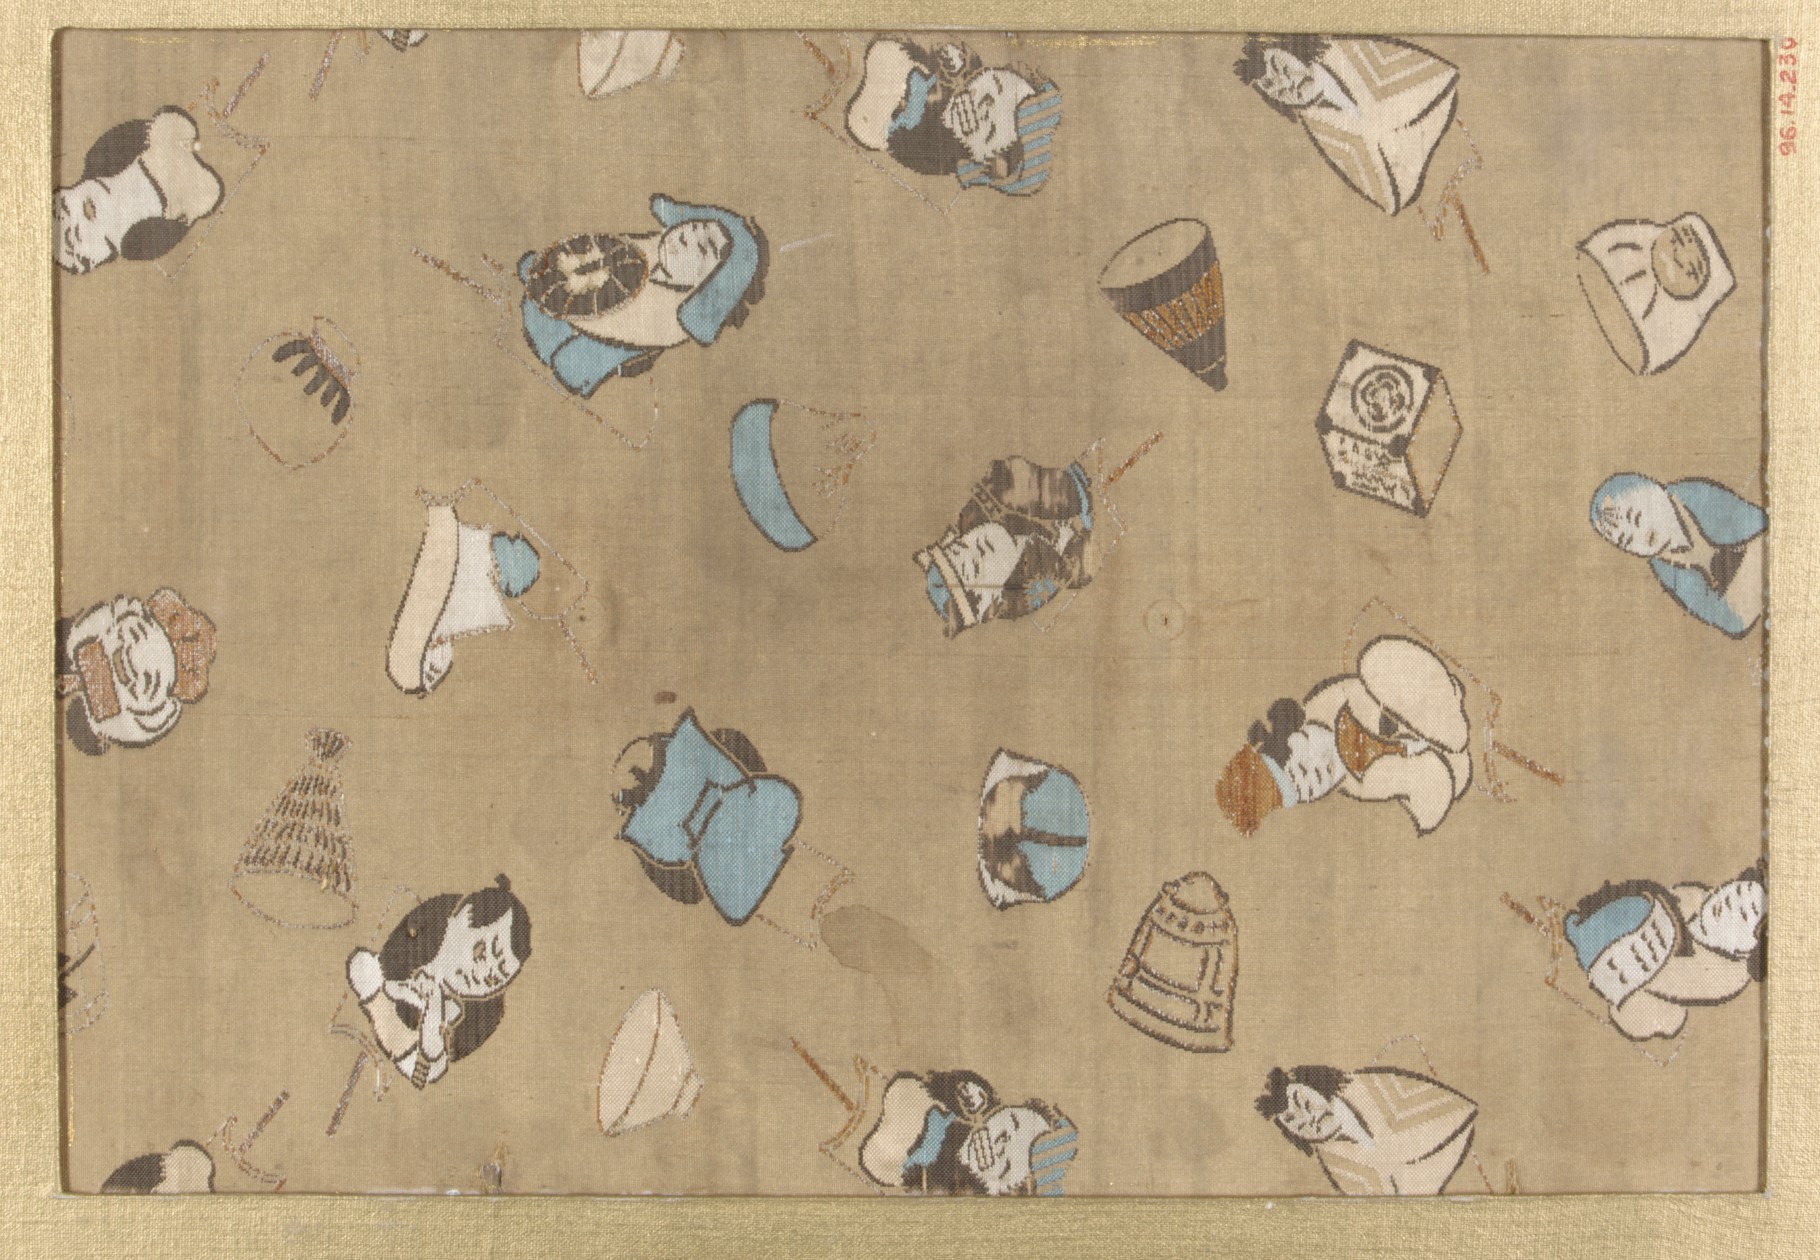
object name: piece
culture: japanese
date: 1701-1900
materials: silk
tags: human figures